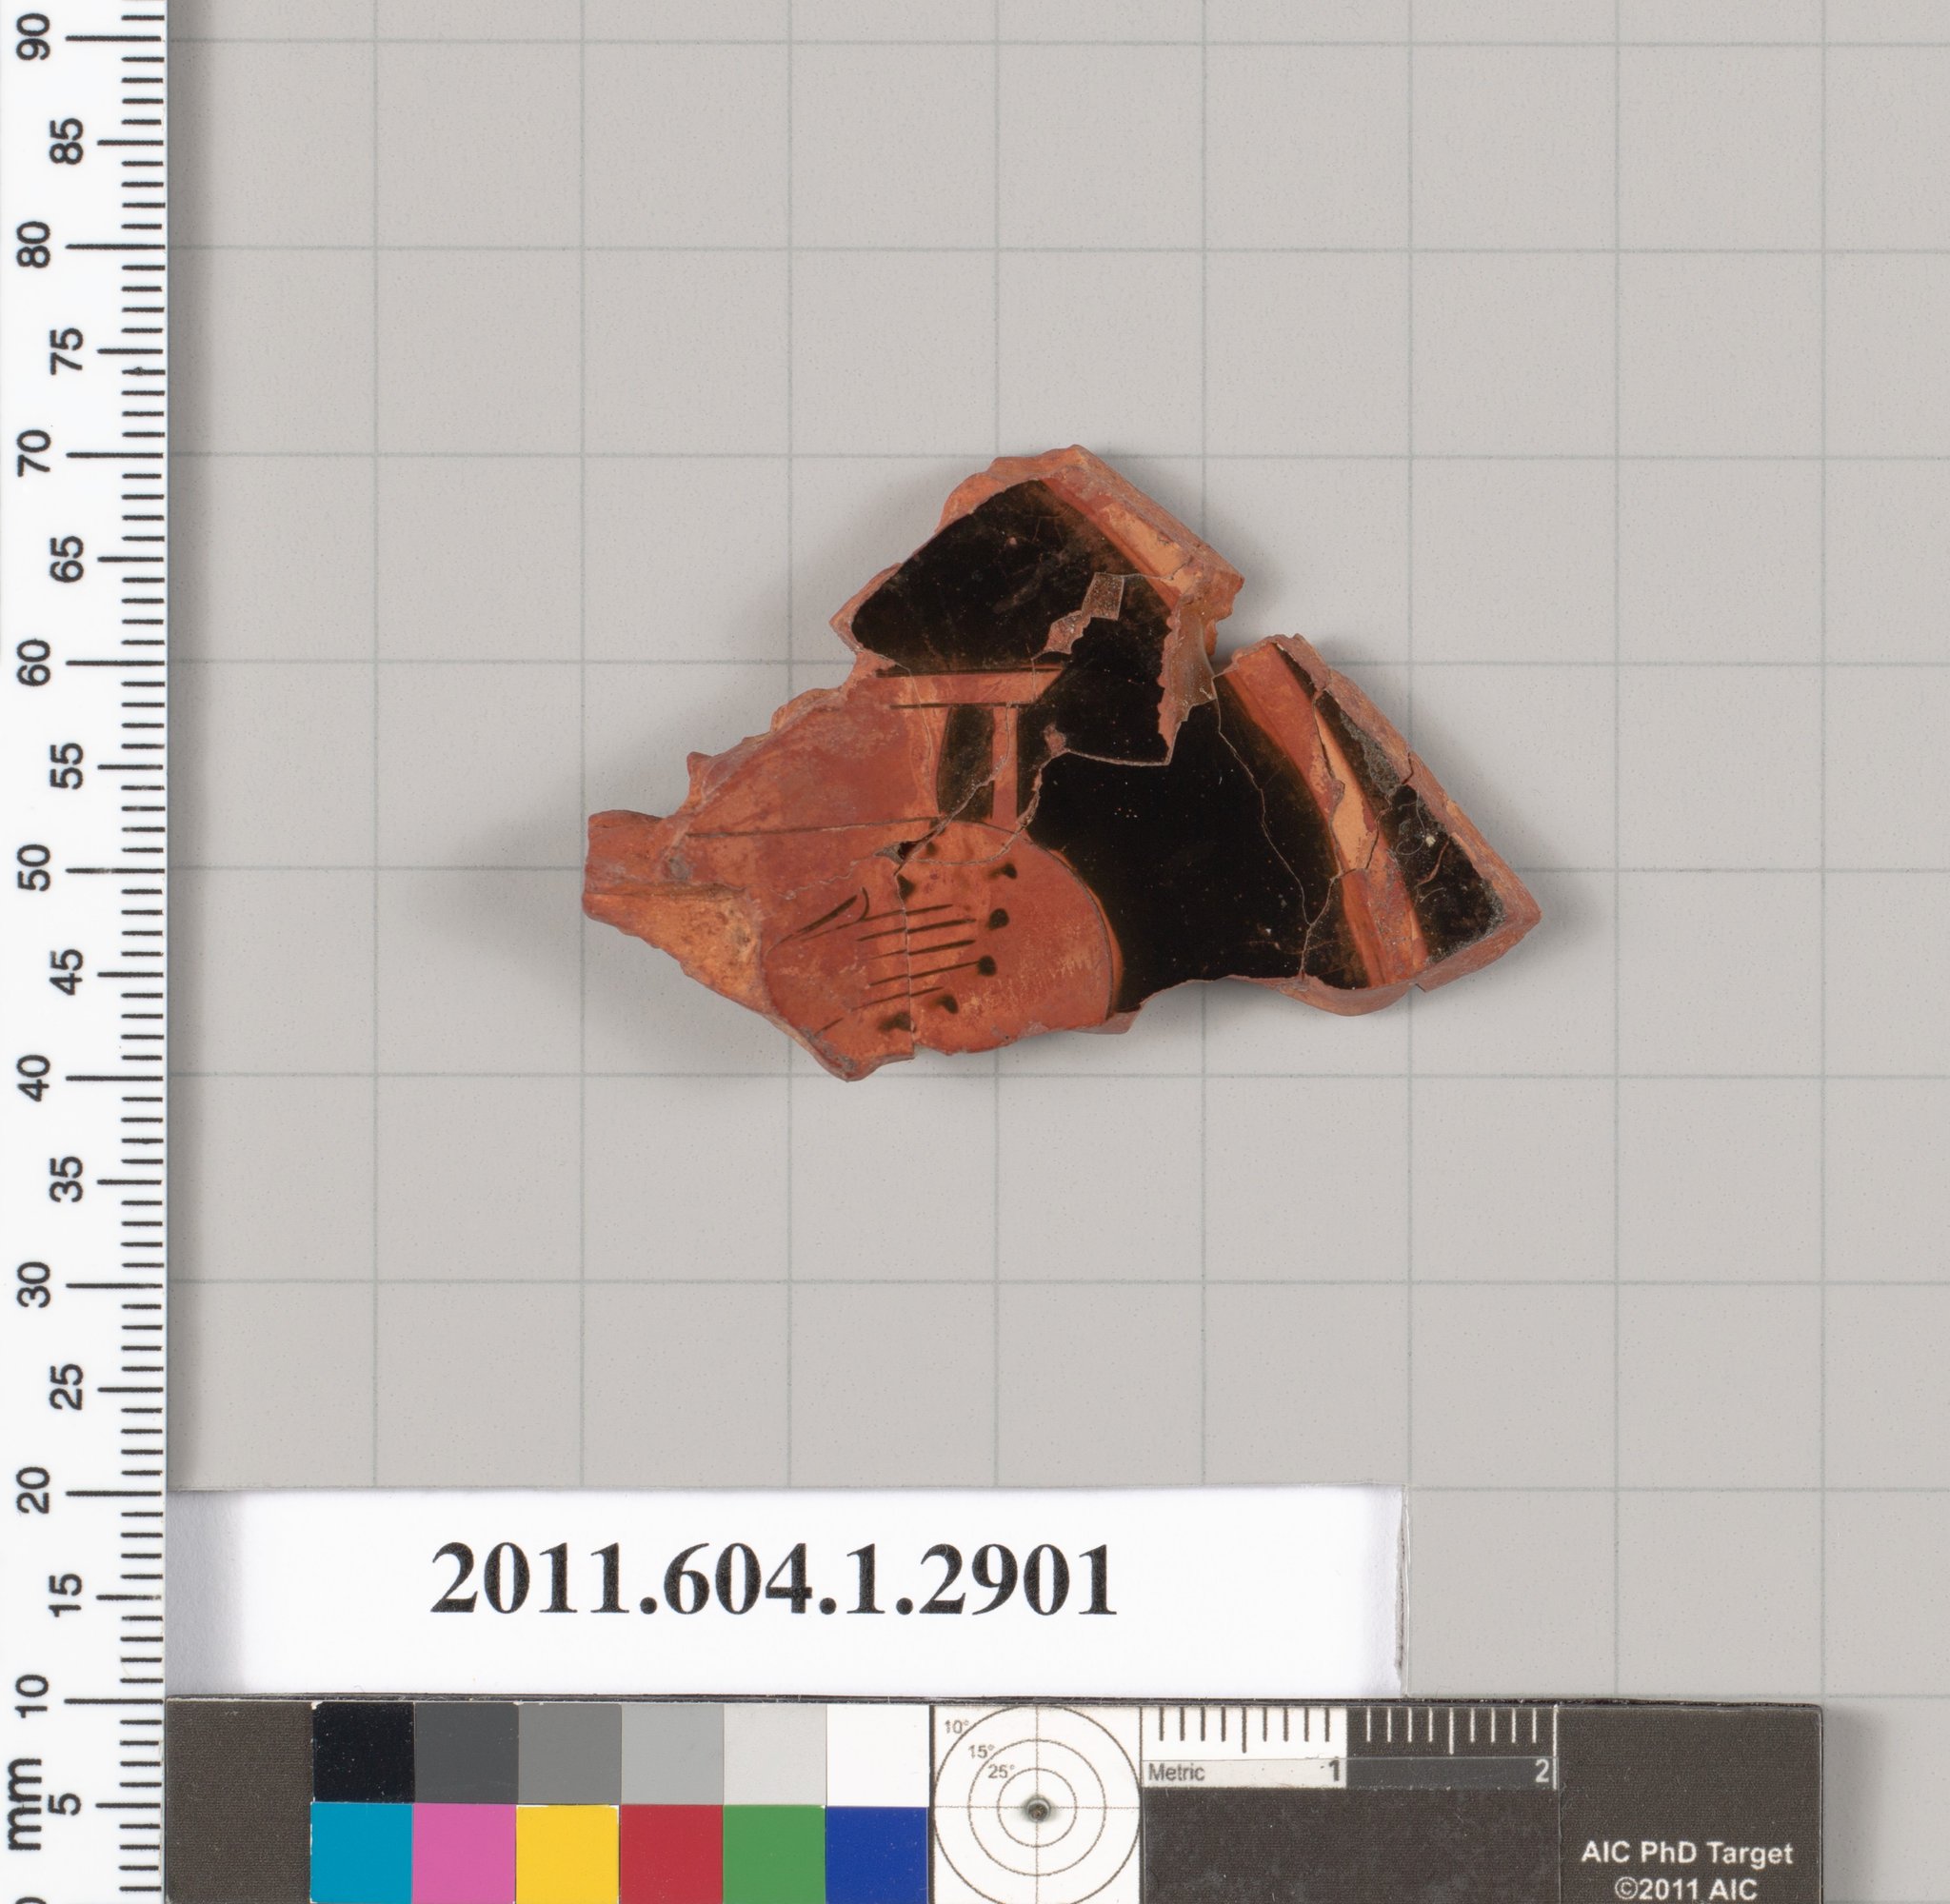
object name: kylix fragment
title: Terracotta fragment of a kylix (drinking cup)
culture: greek, attic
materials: terracotta